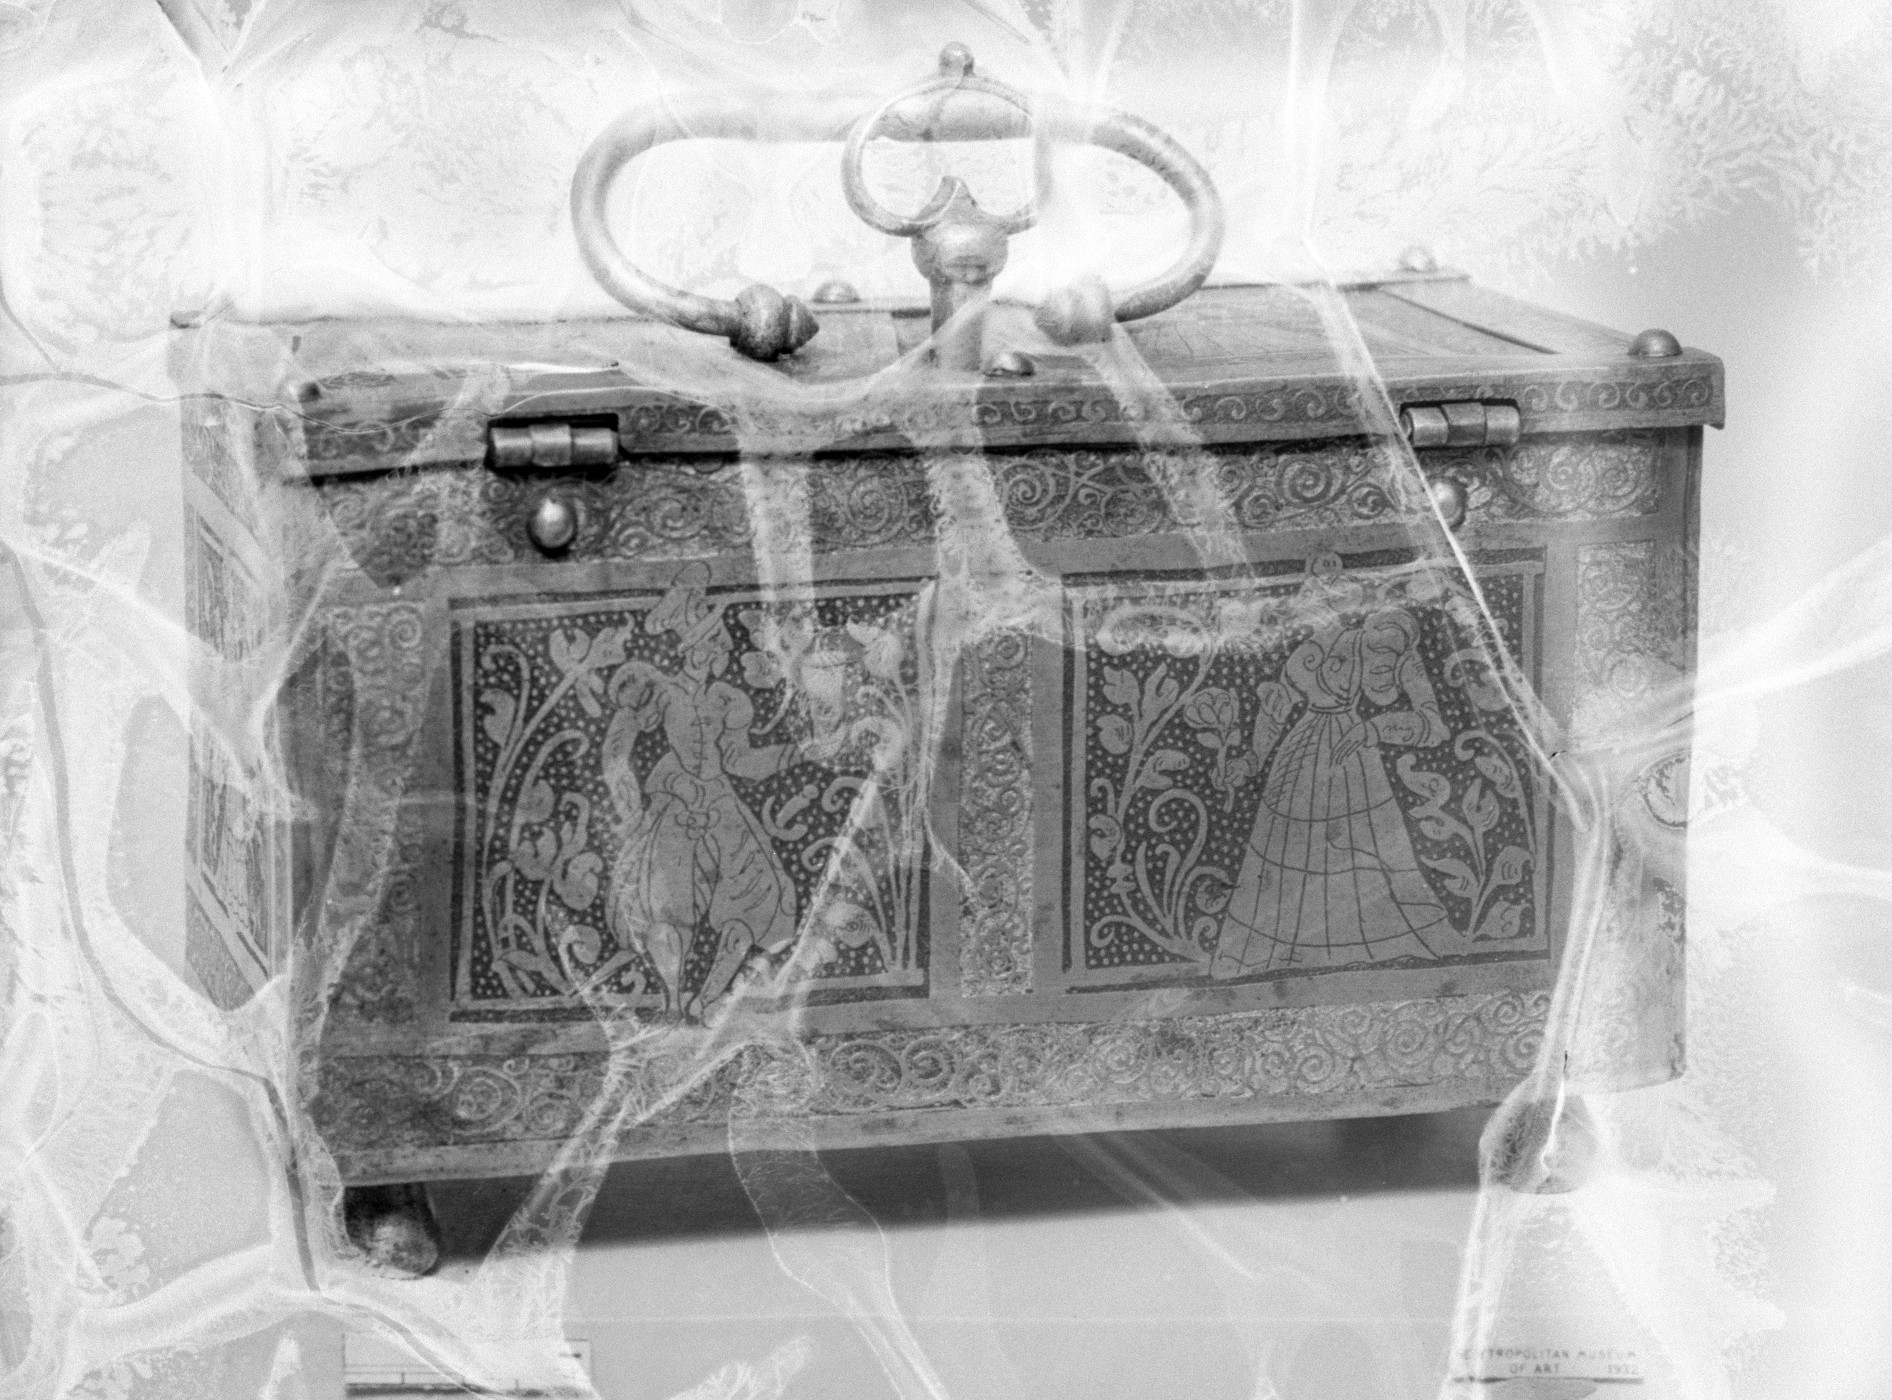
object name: casket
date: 1570-1600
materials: gilt, iron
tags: men,women